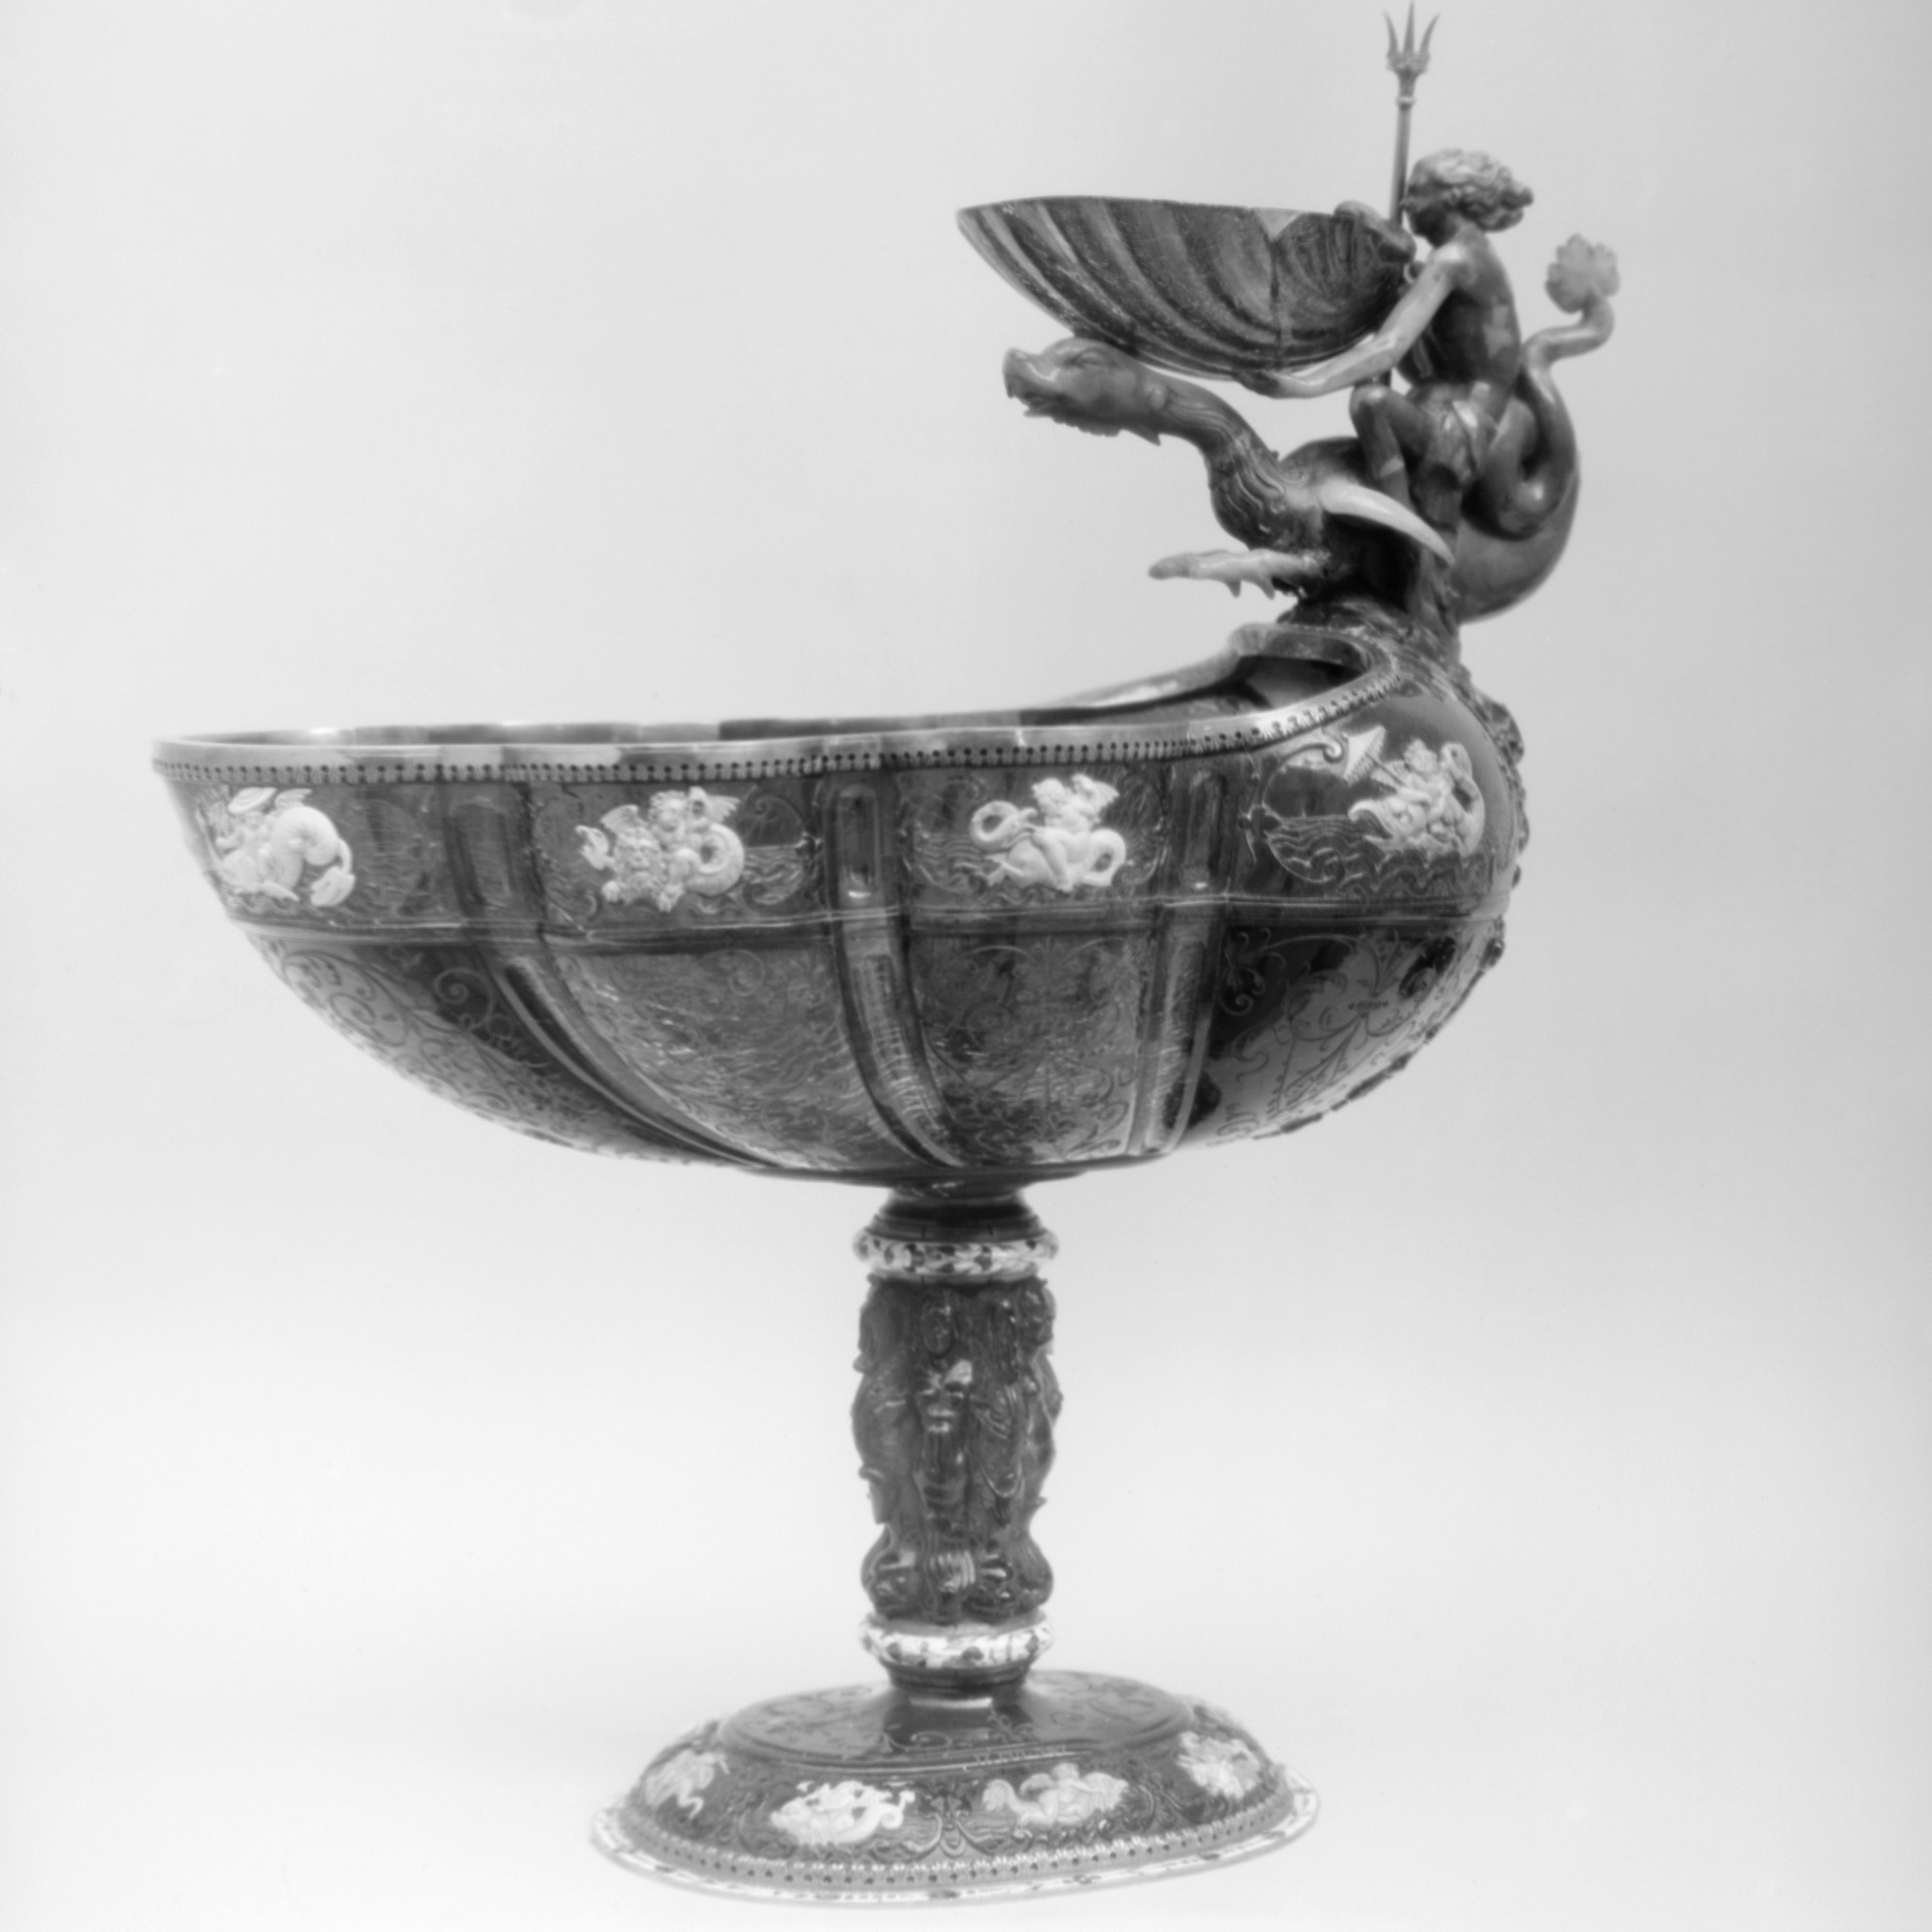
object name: cup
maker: jakob heise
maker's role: maker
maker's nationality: german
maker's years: 1624-1693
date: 1601-1700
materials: amber, enamel, ivory, silver gilt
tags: human figures,dragons